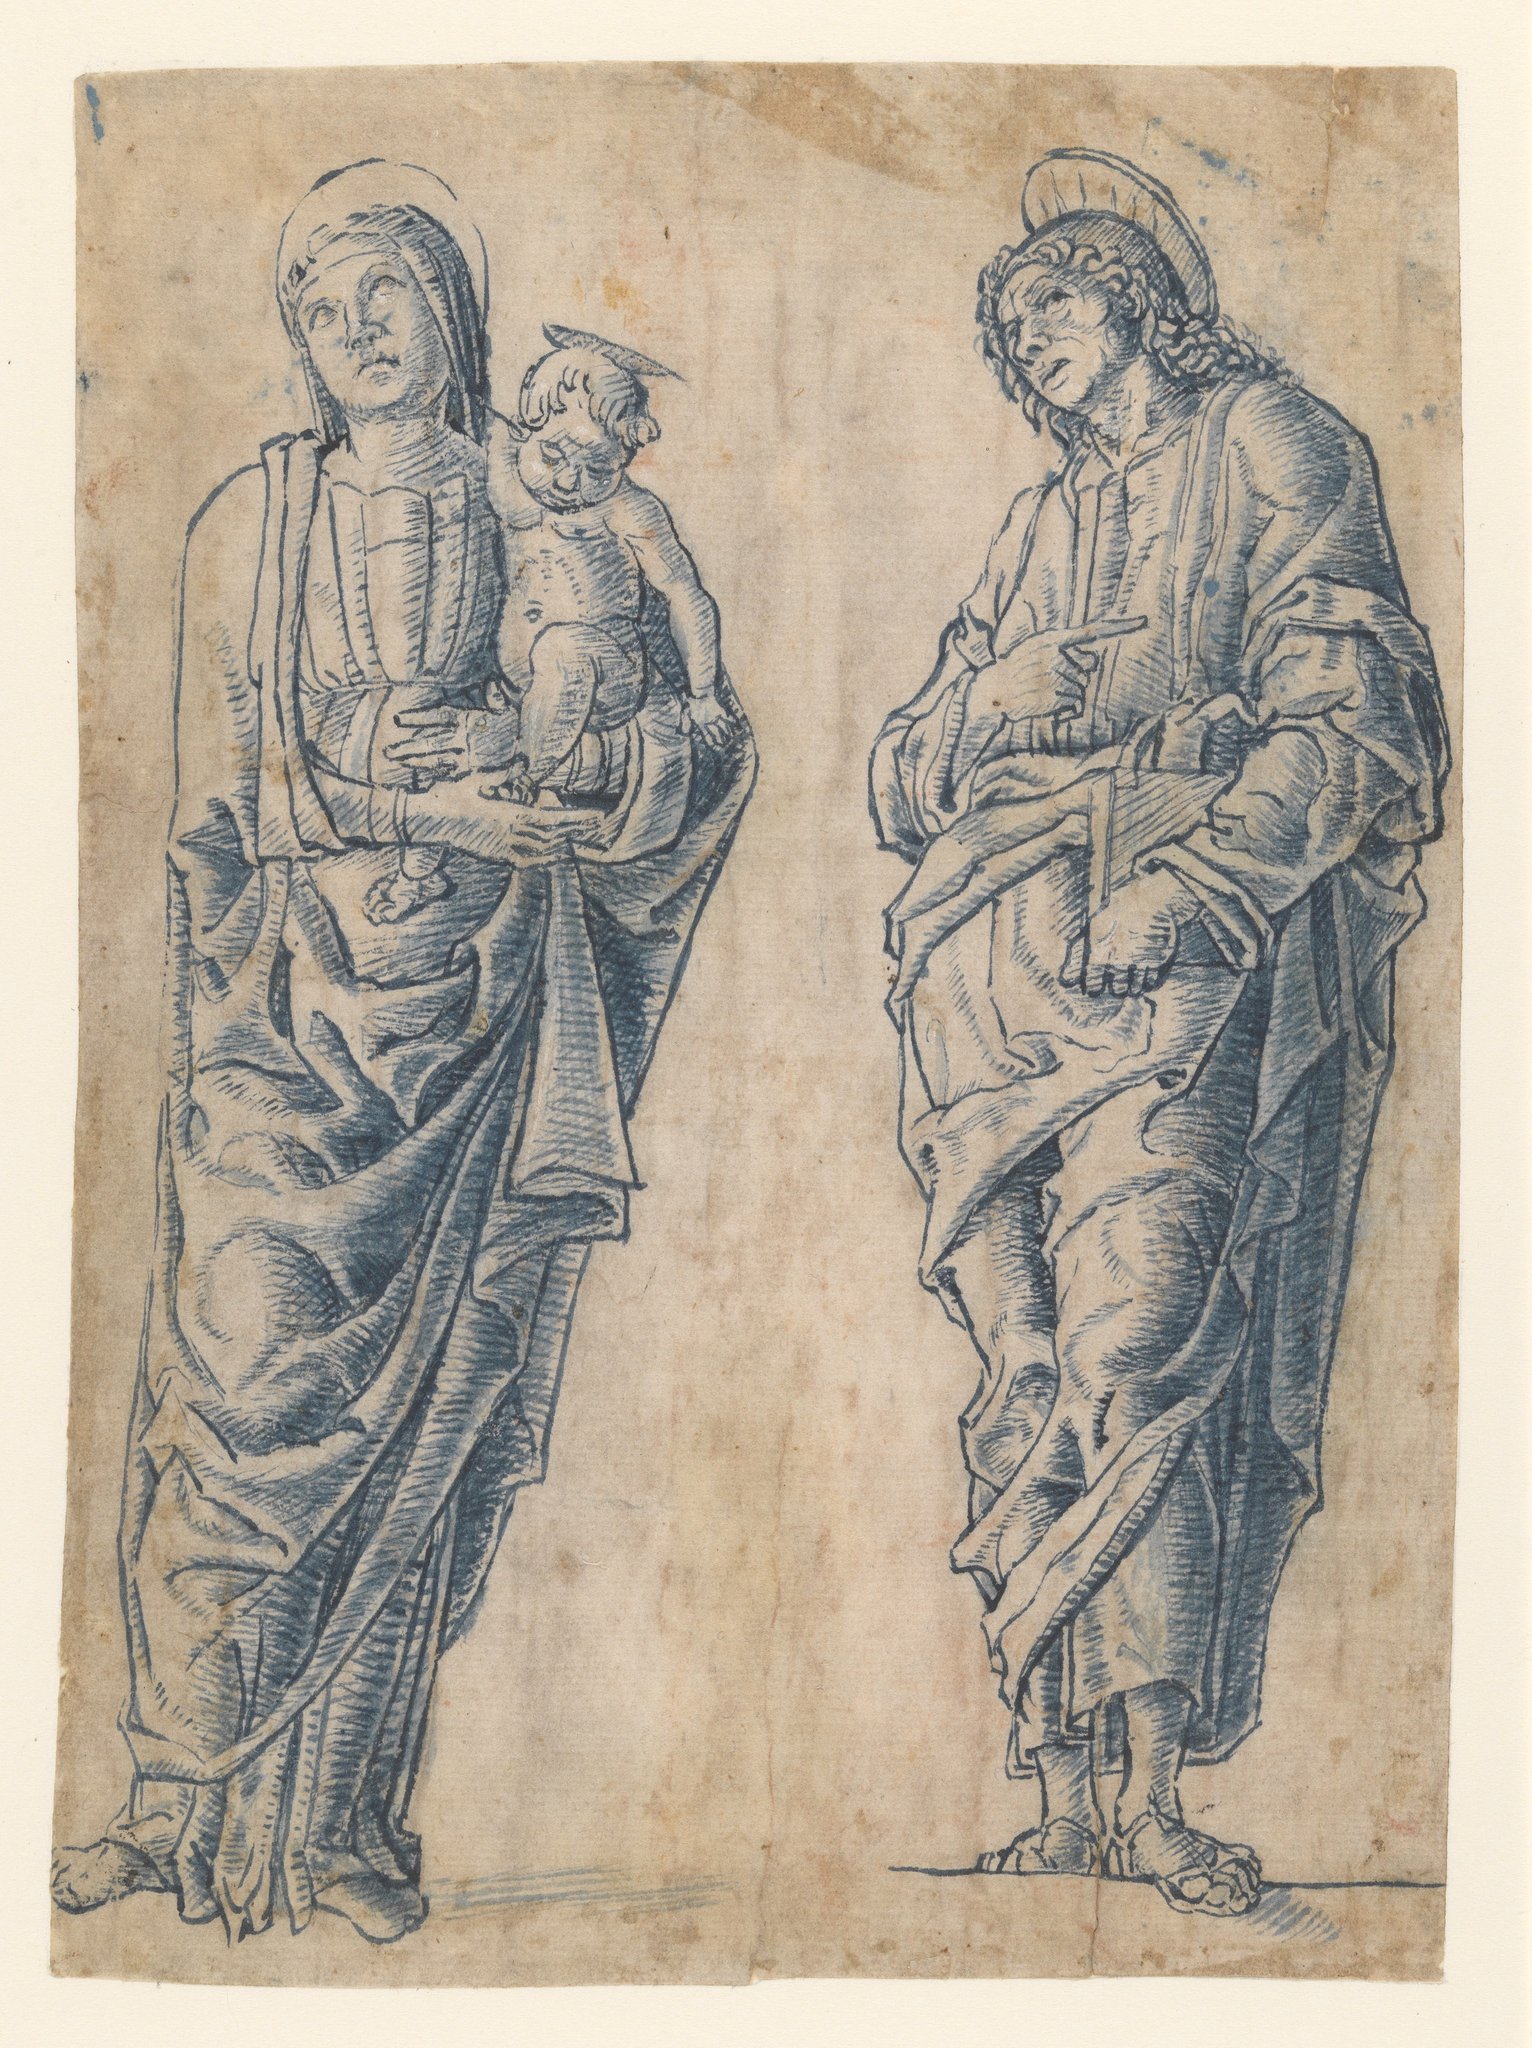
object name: drawing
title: Madonna and Child with Saint John the Evangelist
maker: andrea da murano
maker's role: artist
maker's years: 1462-1507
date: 1467-1533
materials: ink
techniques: brush, pen, wash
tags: madonna and child,saint john the evangelist